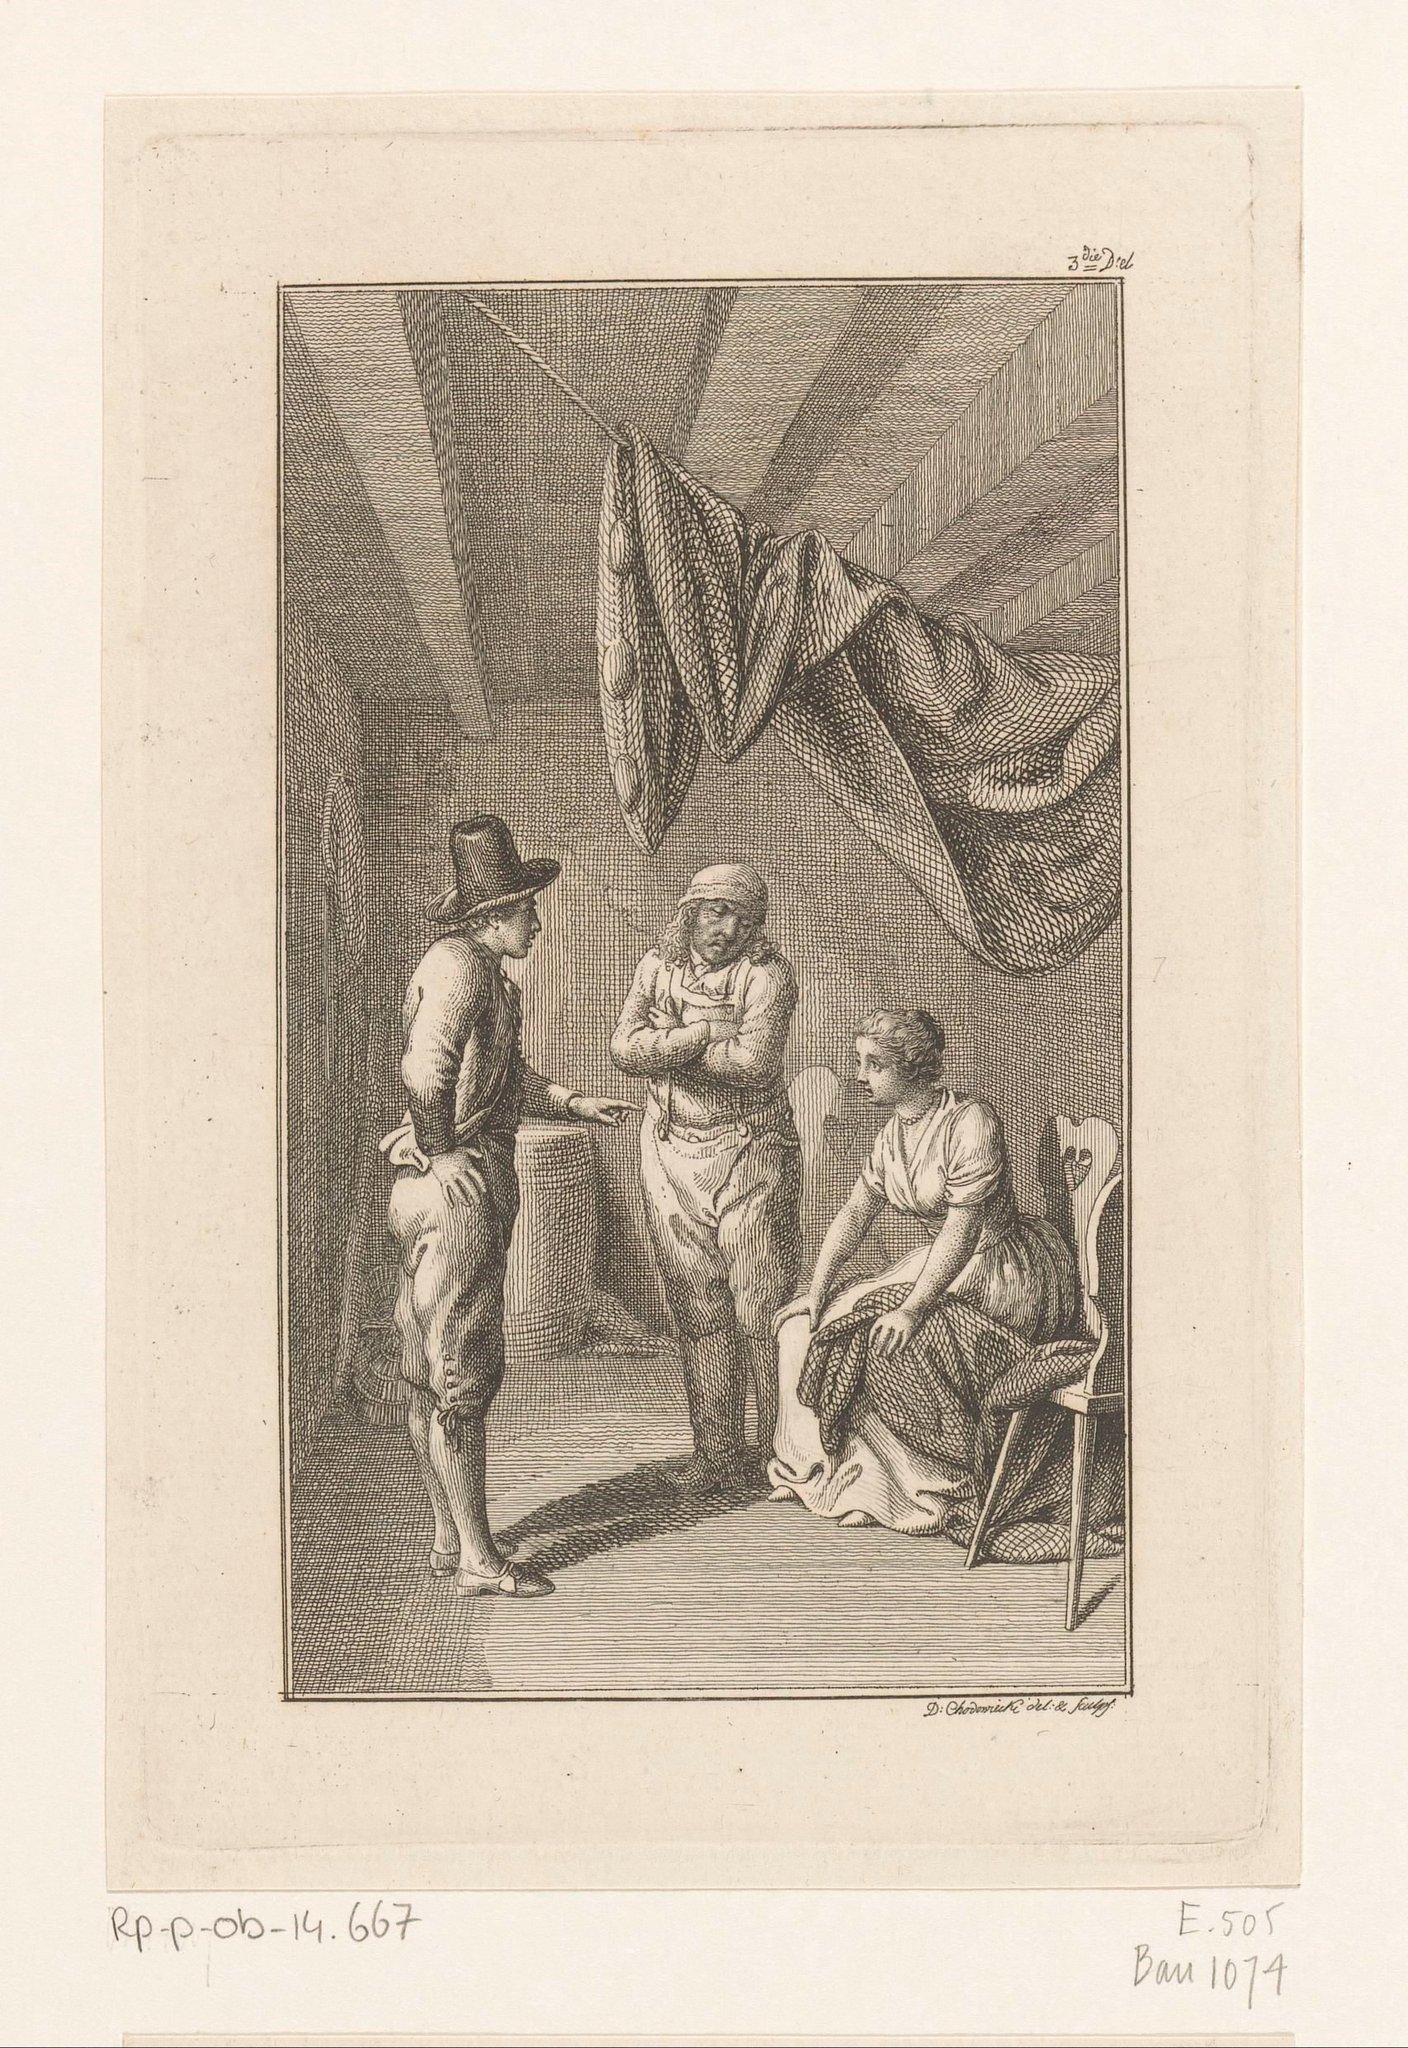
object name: print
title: Martin staand tussen zijn dochter en haar bruidegom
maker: daniel nikolaus chodowiecki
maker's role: draughtsman, print maker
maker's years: 1726-1801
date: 1784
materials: paper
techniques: etching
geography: berlin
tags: copenhagen (city), literature, fisherman, making of fishing nets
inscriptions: collector's mark: Lugt 2228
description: Prent uit: Ewald, Johannes. Johannes Ewald's samtlige Skrifter (...). 4 dln. Kopenhagen: Christ. Gottlob Proft, 1781-1791, dl. 3.